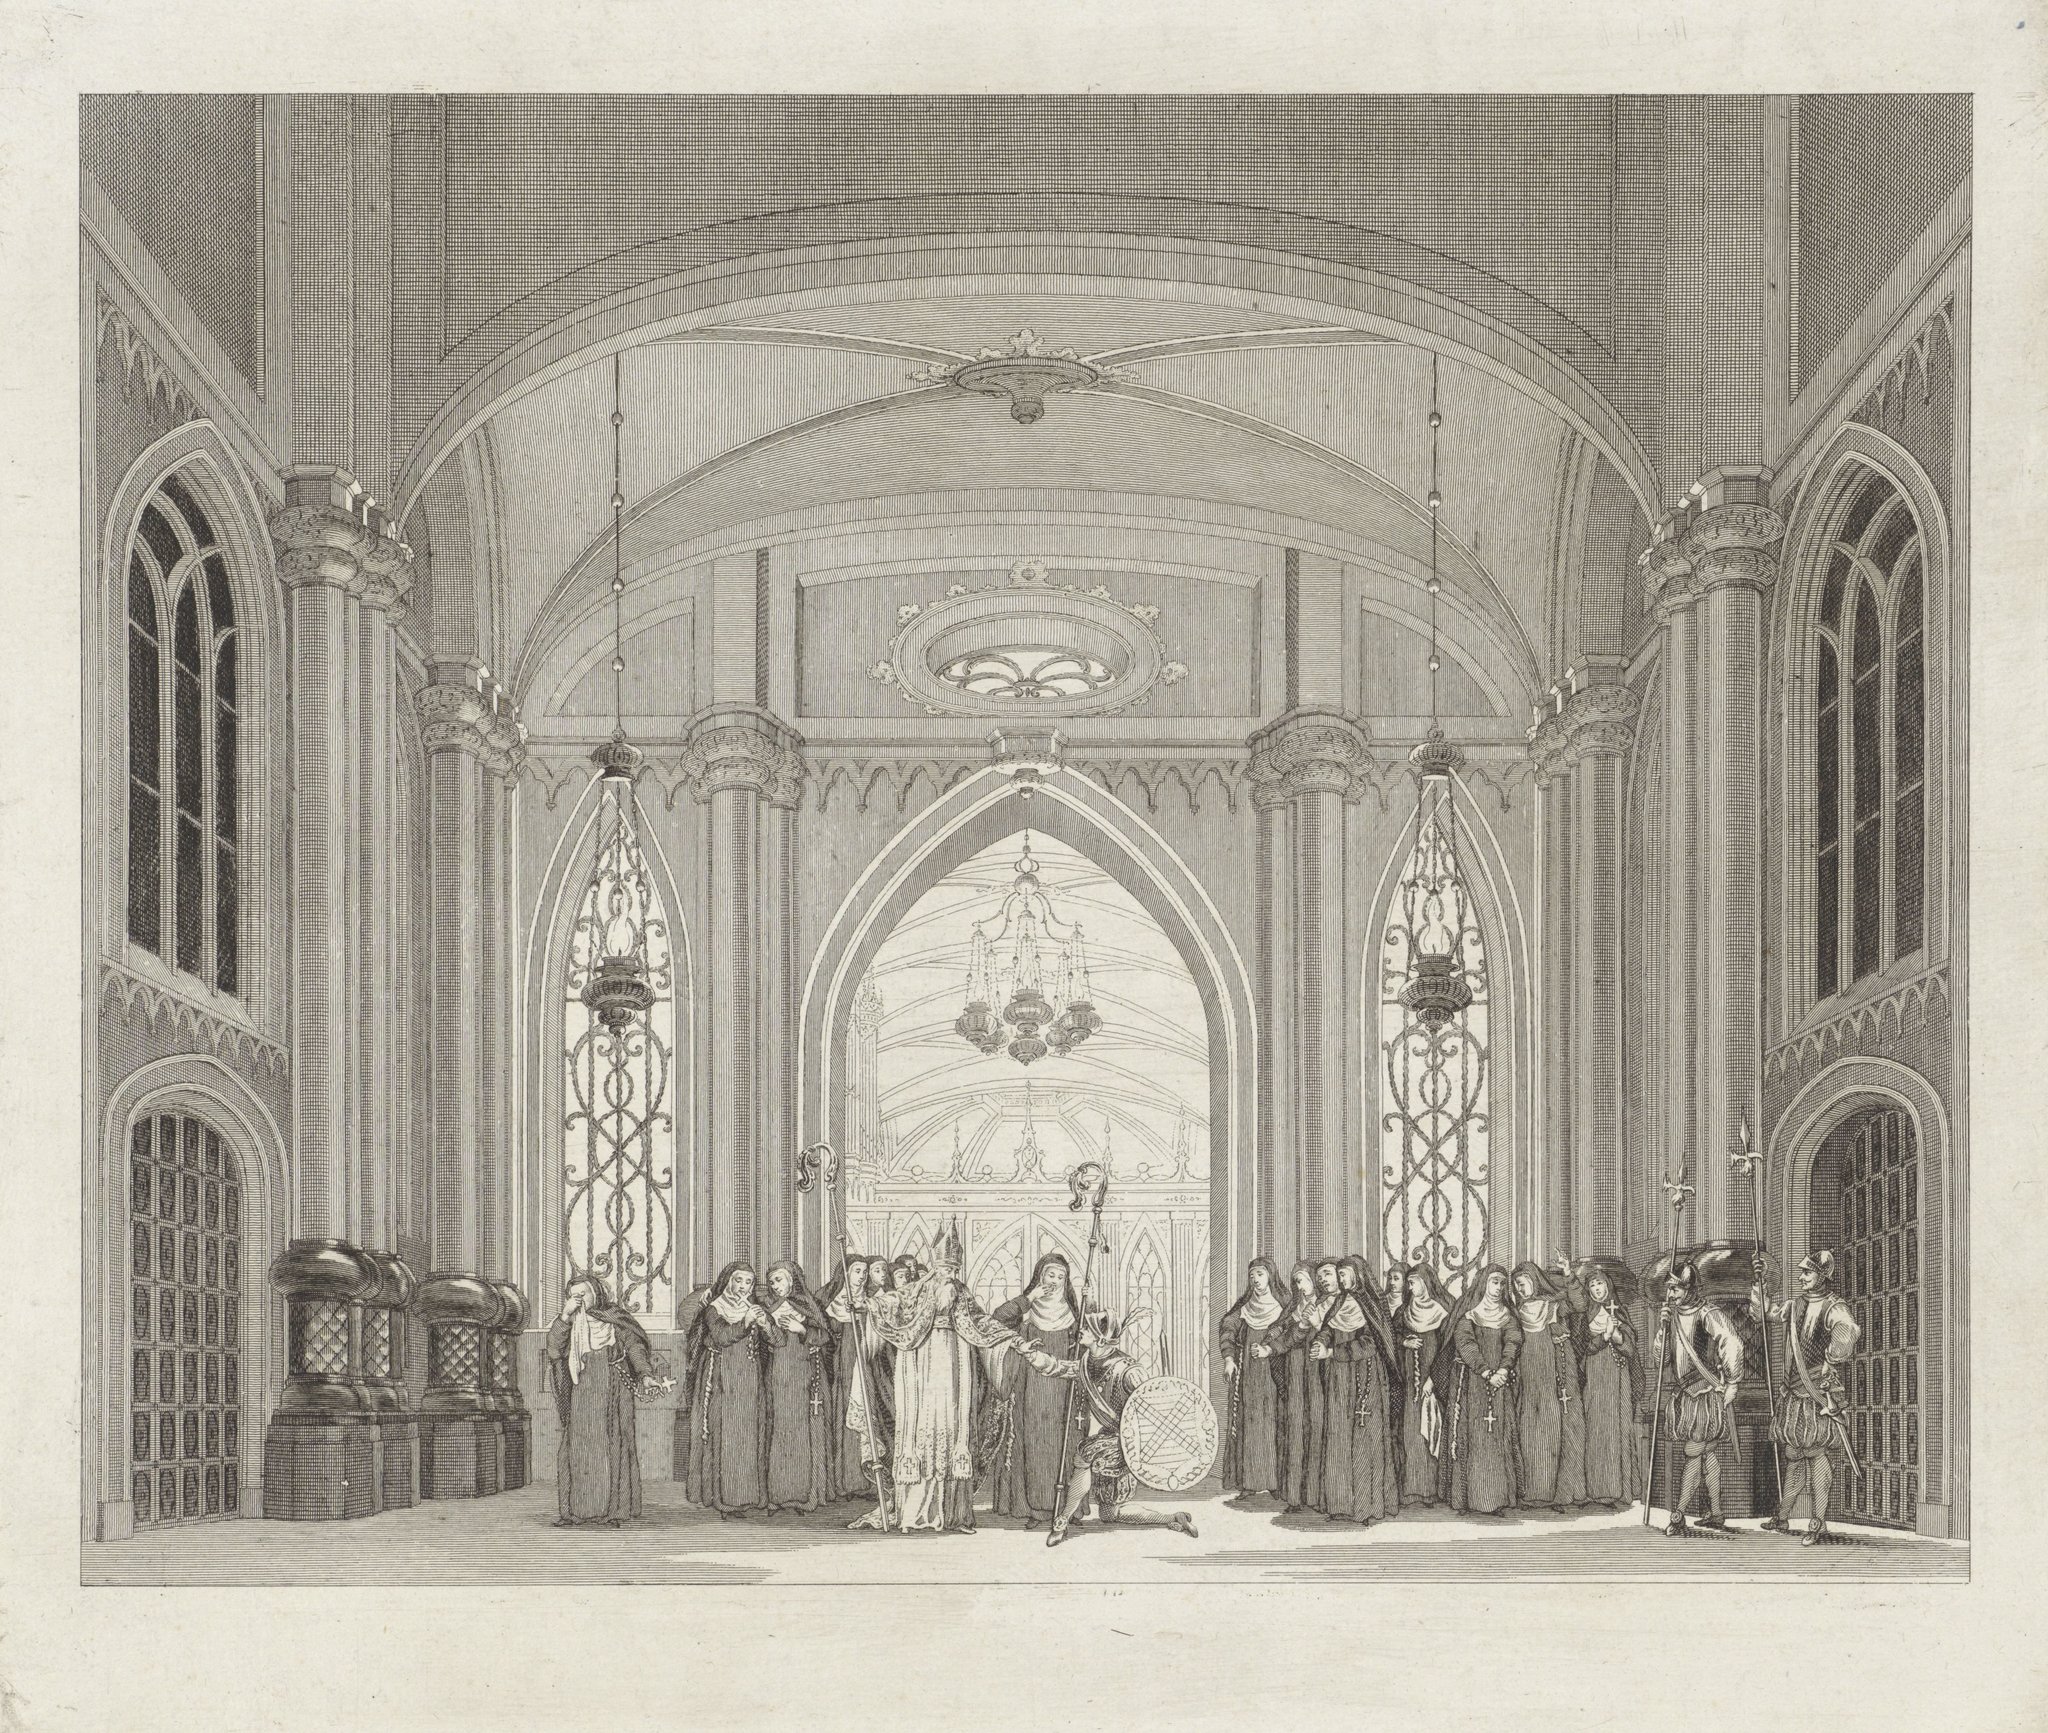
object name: print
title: Toneeldecors van de nieuwe Amsterdamse Schouwburg, 1775-1777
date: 1776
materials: paper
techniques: etching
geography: amsterdam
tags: cologne, amsterdam, joost van den vondel, theatre, theatrical performance, stage design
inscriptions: collector's mark: Lugt 240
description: Het coulissendecor De Klooster-Kapel, met een scène uit: De Gijsbrecht van Aemstel. Onderdeel van een serie van zes toneeldecors van toneelstukken opgevoerd in de nieuwe Amsterdamse Schouwburg uit de jaren 1775-1777.